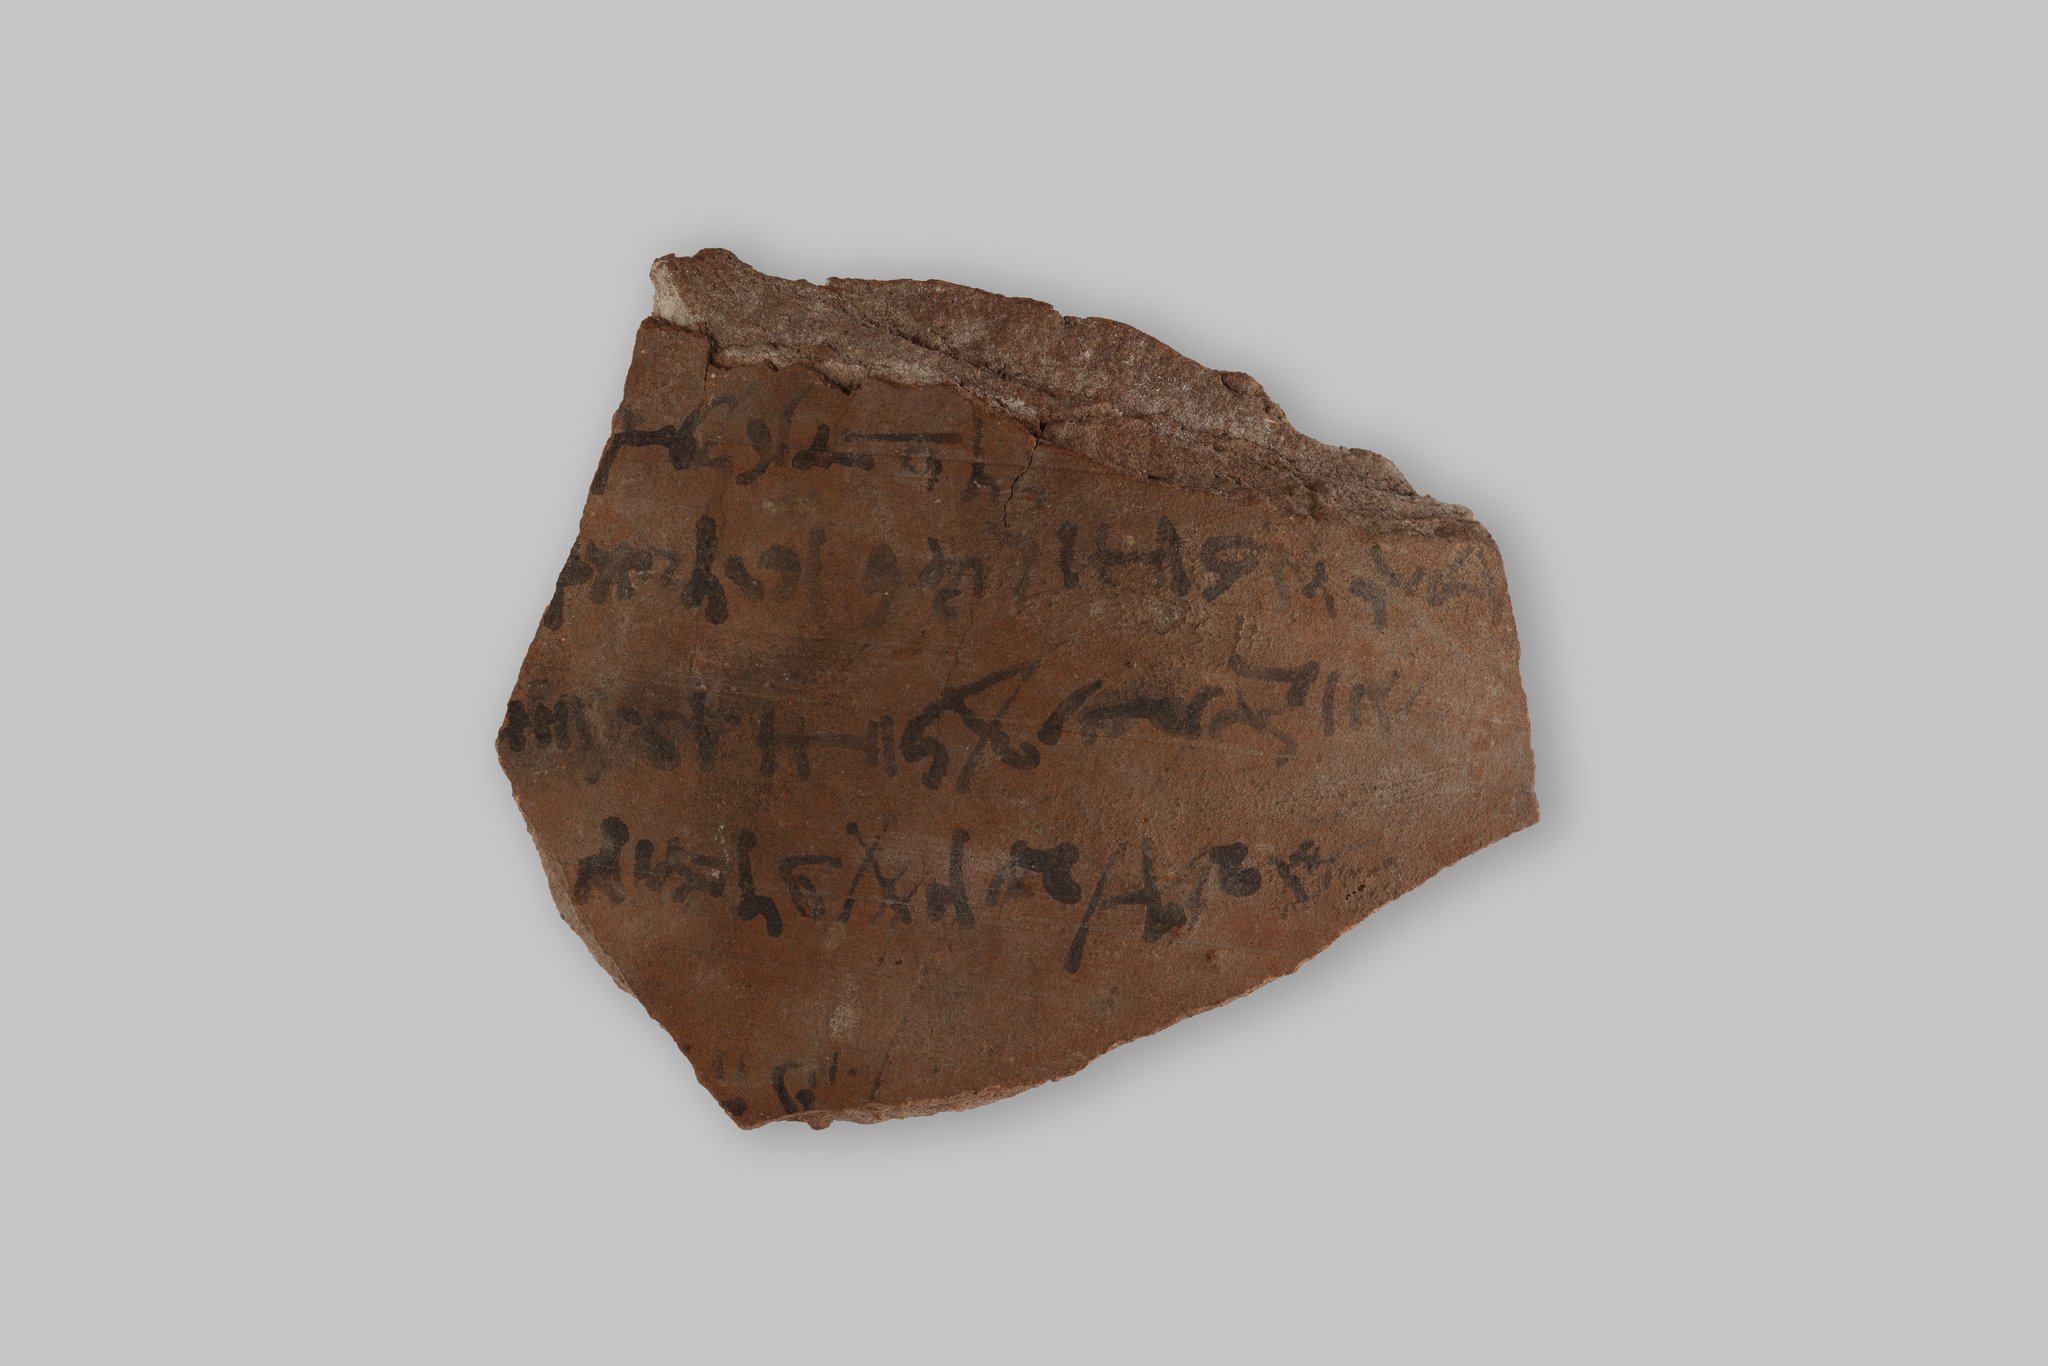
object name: ostracon, demotic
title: Ostracon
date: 600-30 BCE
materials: ink, pottery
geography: egypt